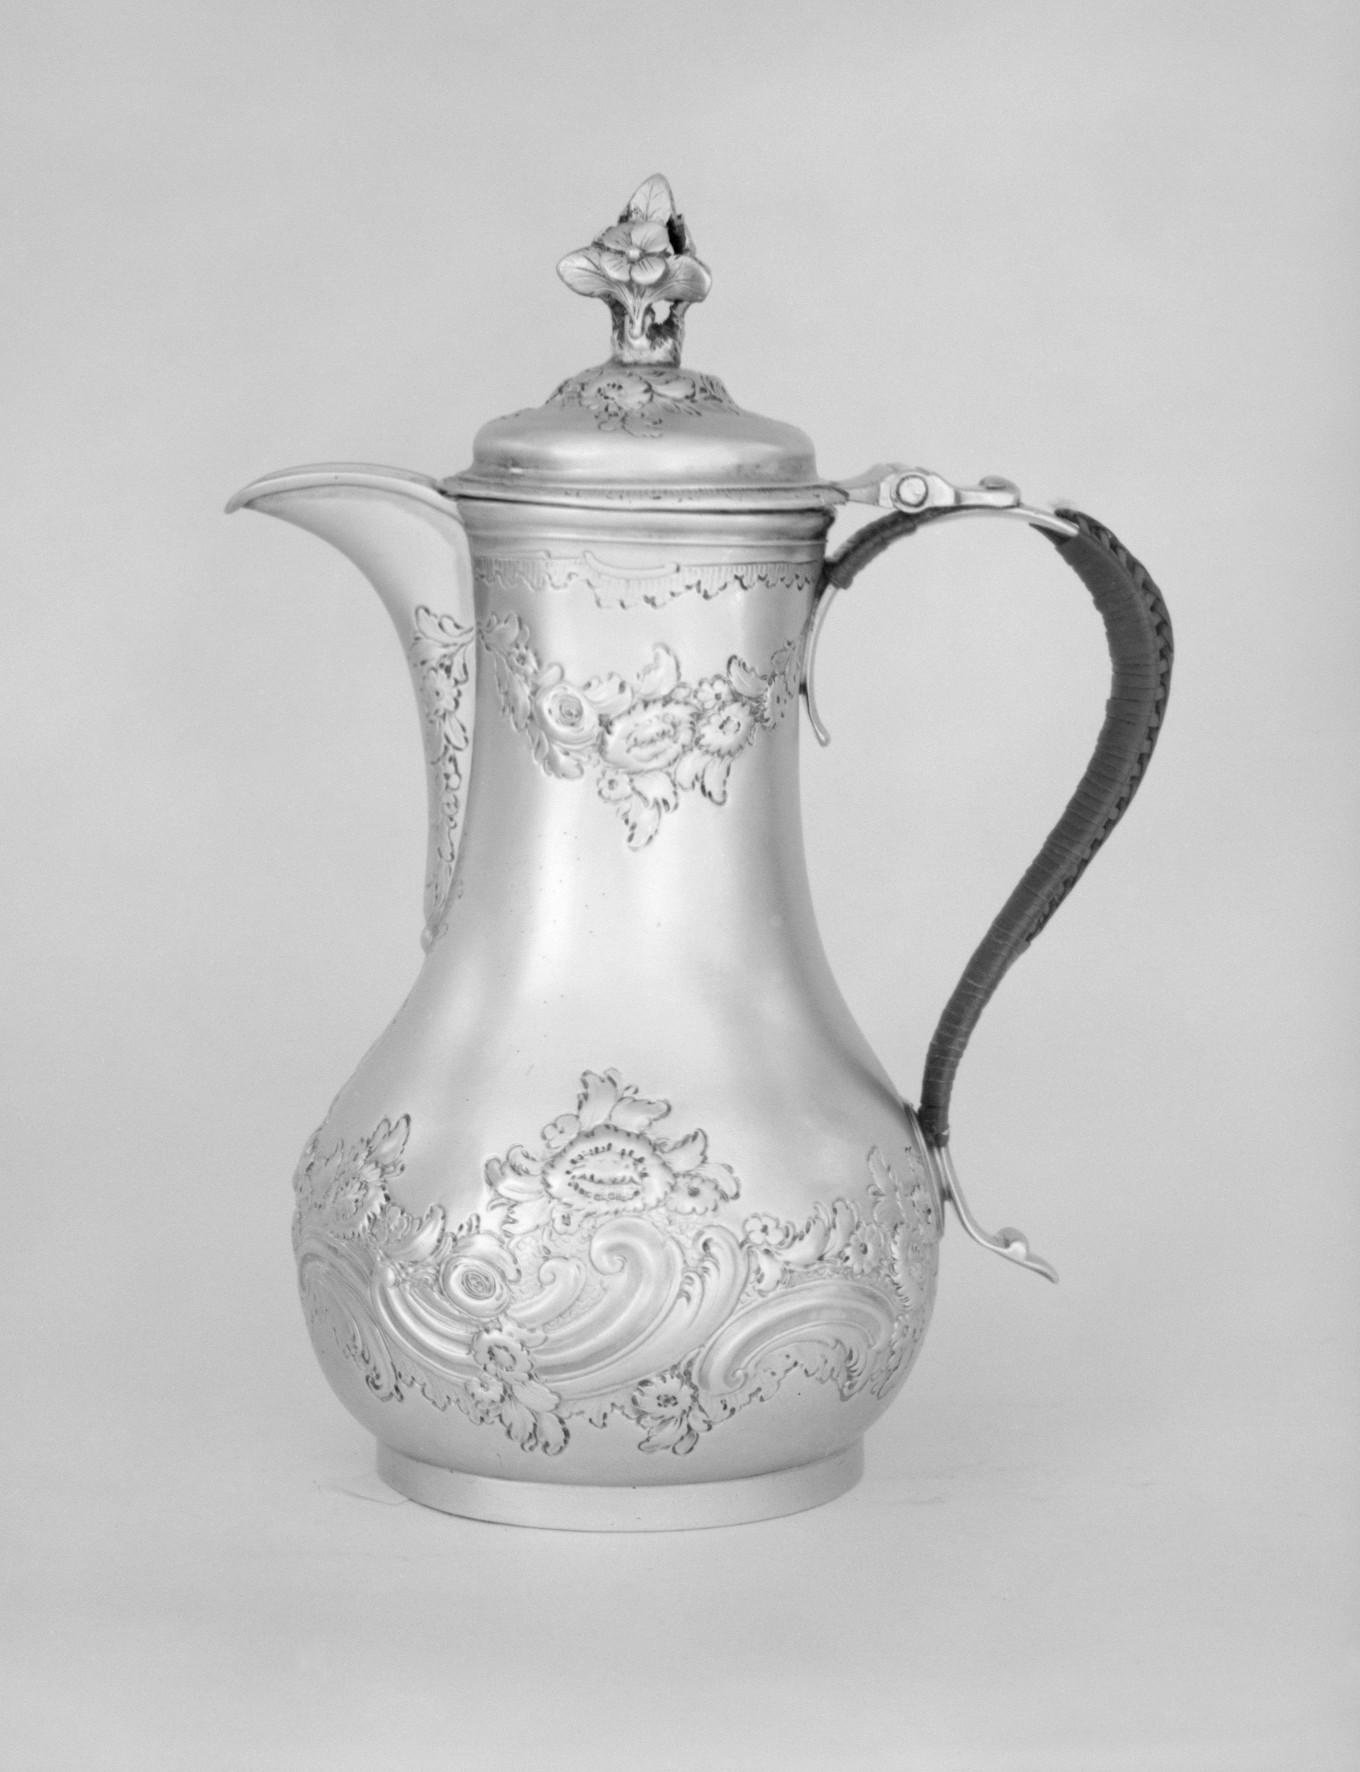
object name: hot water jug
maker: paul de lamerie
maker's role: maker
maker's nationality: british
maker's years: 1688-1751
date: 1748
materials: silver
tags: flowers